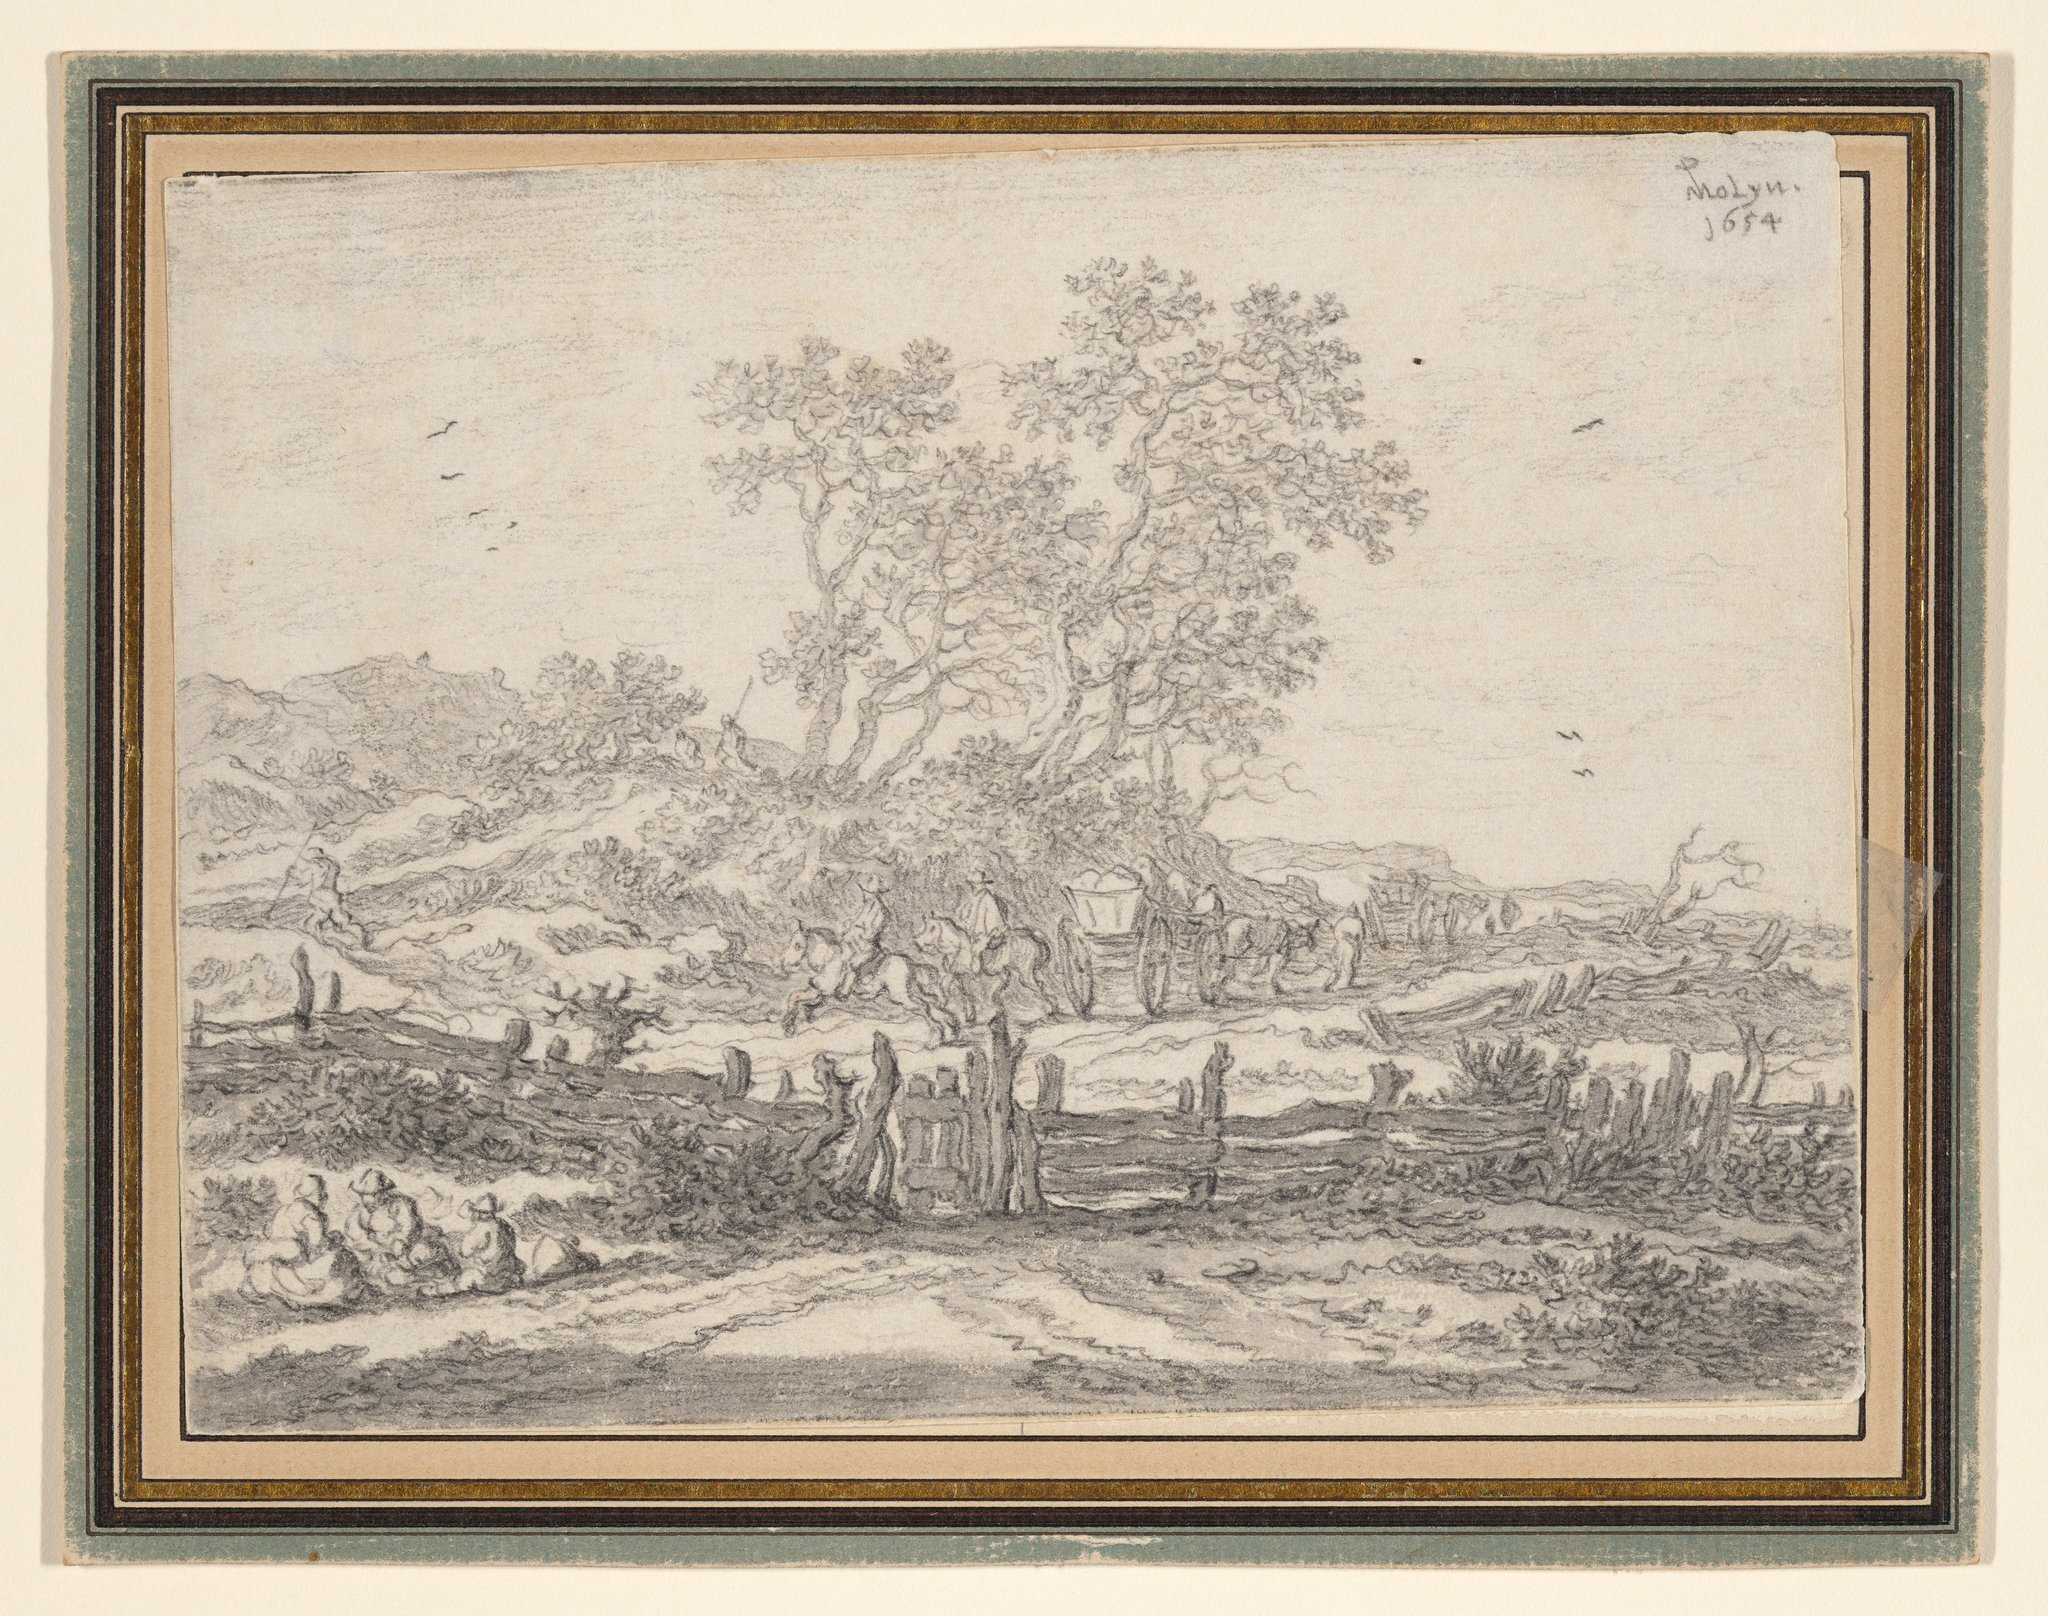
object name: drawing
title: A Landscape with Travelers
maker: pieter de molijn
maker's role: artist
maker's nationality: dutch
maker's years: 1595-1661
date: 1654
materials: chalk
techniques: wash